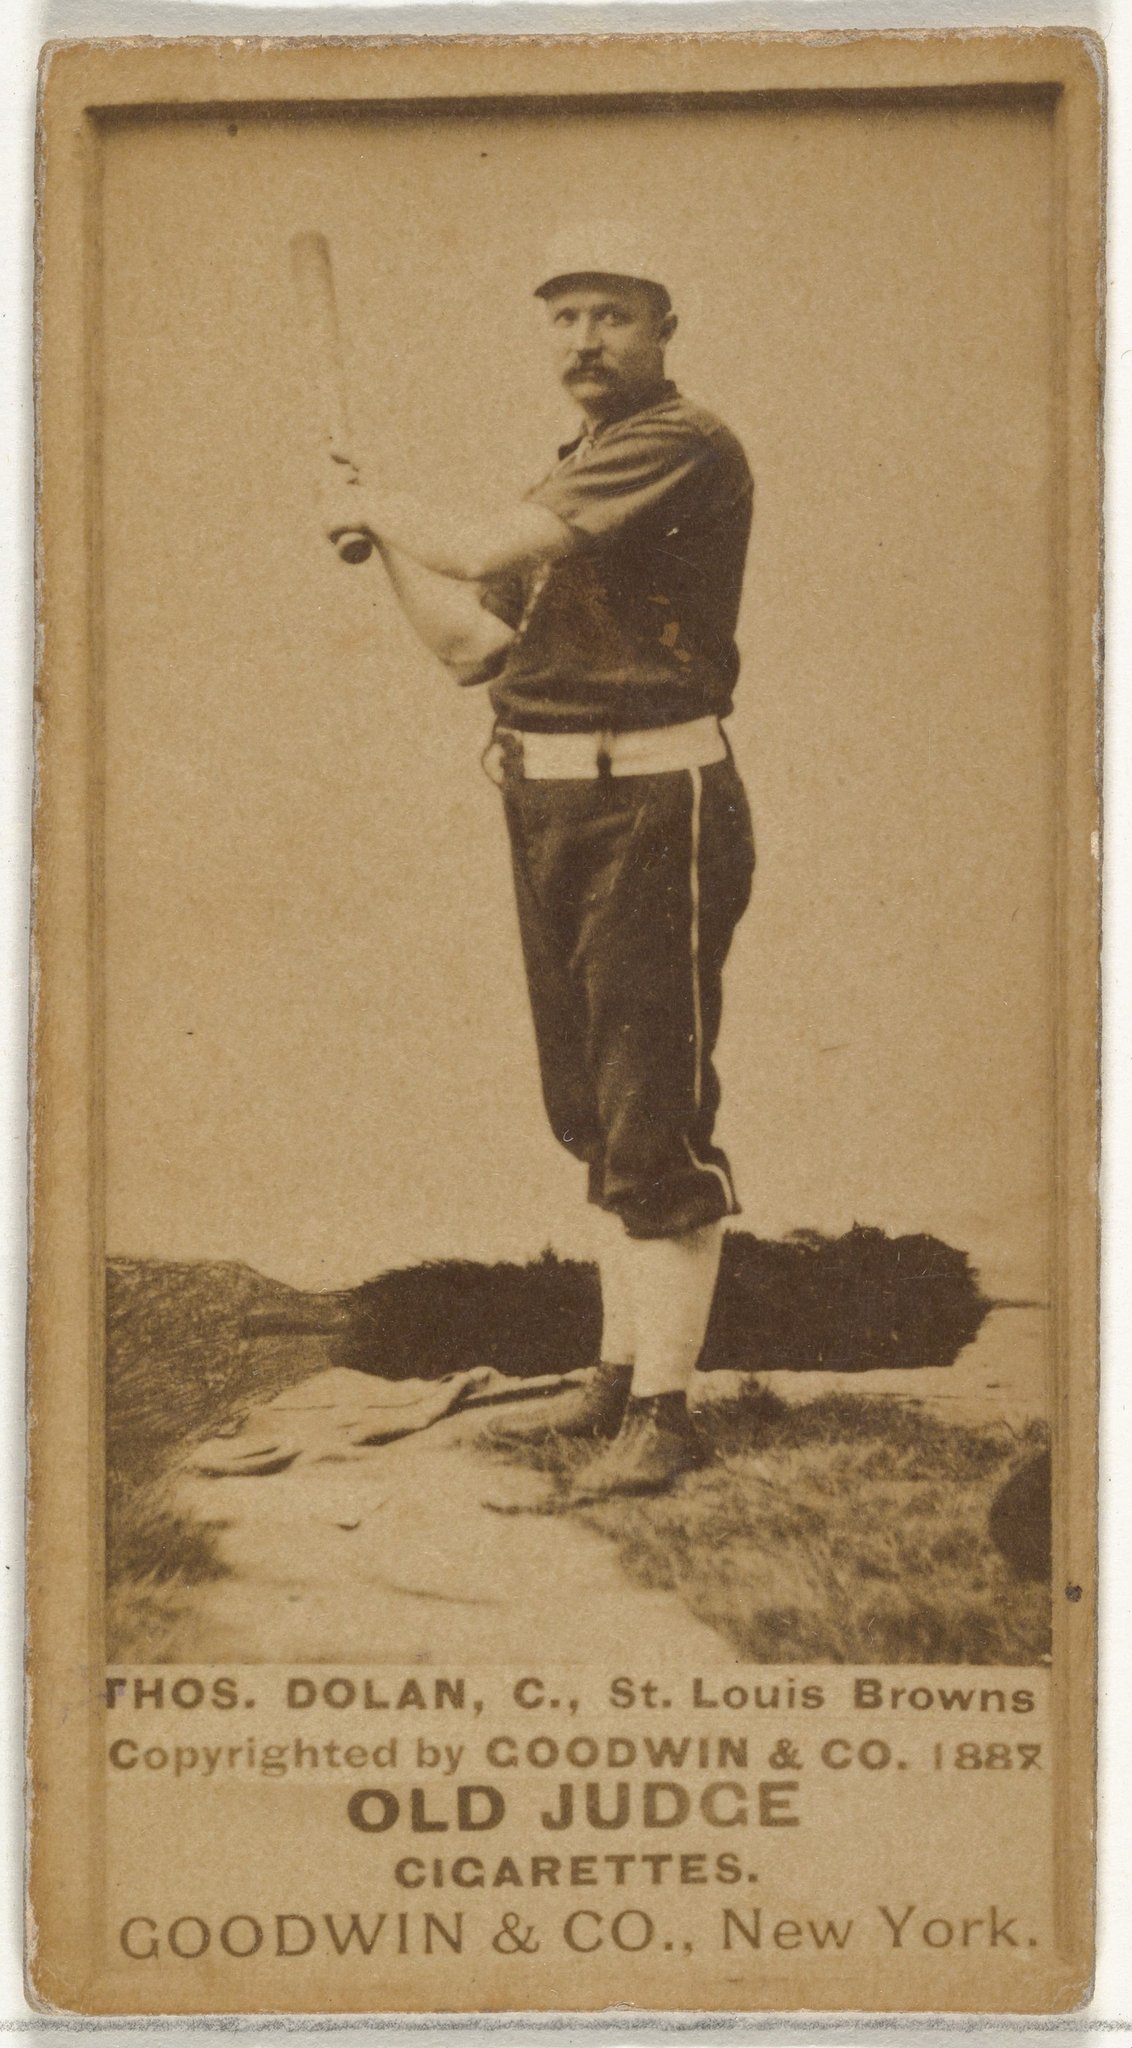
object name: baseball card, photograph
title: Thomas J. "Tom" Dolan, Catcher, St. Louis Browns, from the Old Judge series (N172) for Old Judge Cigarettes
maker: goodwin & company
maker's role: publisher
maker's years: 1850-1950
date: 1888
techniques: albumen silver print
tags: men,portraits,baseball,athletes